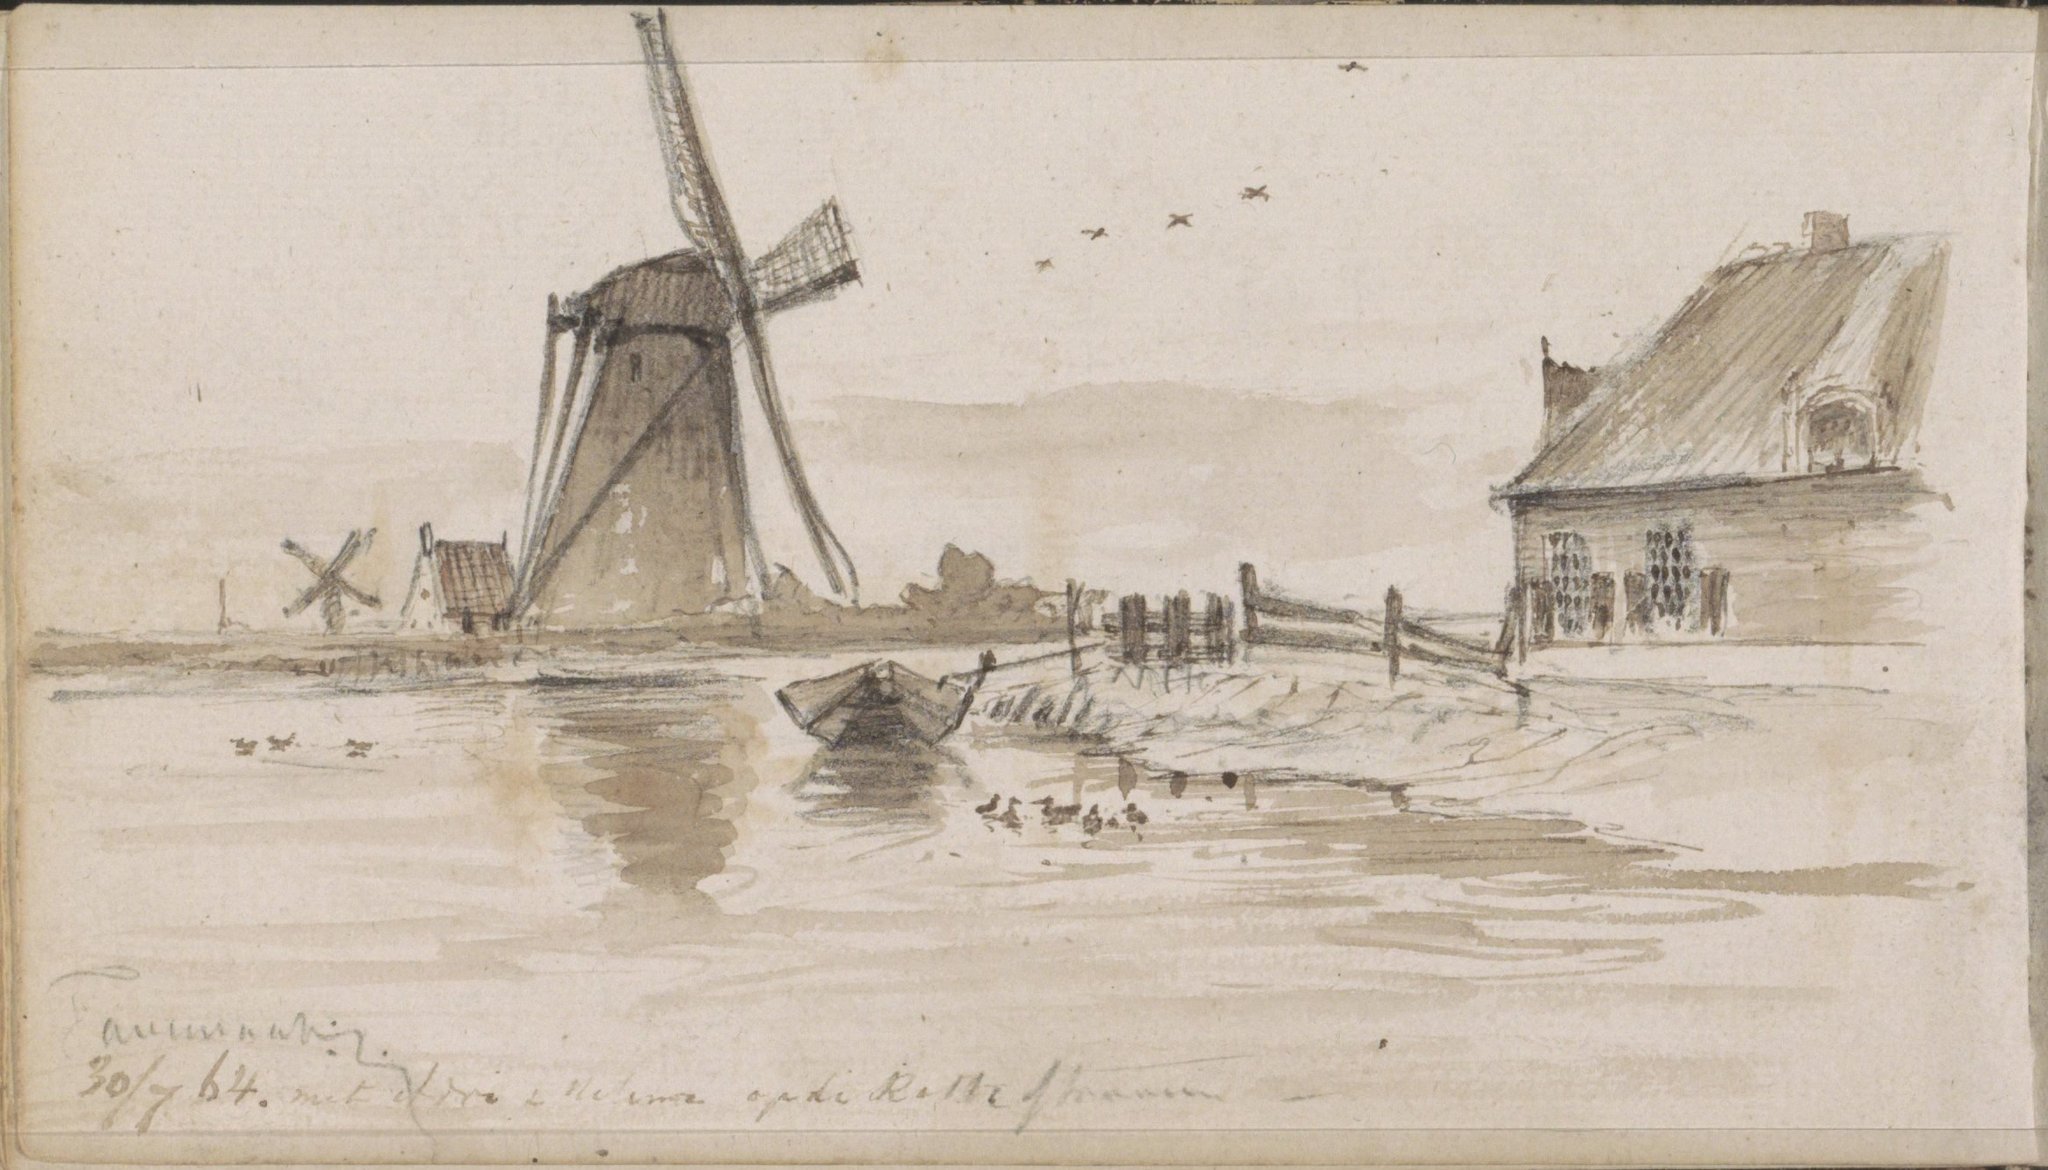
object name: sketchbook leaf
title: Molens en huizen aan de Rotte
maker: johannes tavenraat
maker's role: draughtsman, painter, print maker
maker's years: 1809-1881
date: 1807-1864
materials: ink, paper, pencil, watercolor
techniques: brush, pen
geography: rotte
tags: river, windmill in landscape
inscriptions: signature: ‘Tavenraat’, date and inscription: ‘30/7 64. met Ad[...] & Helena op de Rotte [...]’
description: Vanaf de rivier getekend. Blad 7 verso uit een schetsboek met 98 bladen.